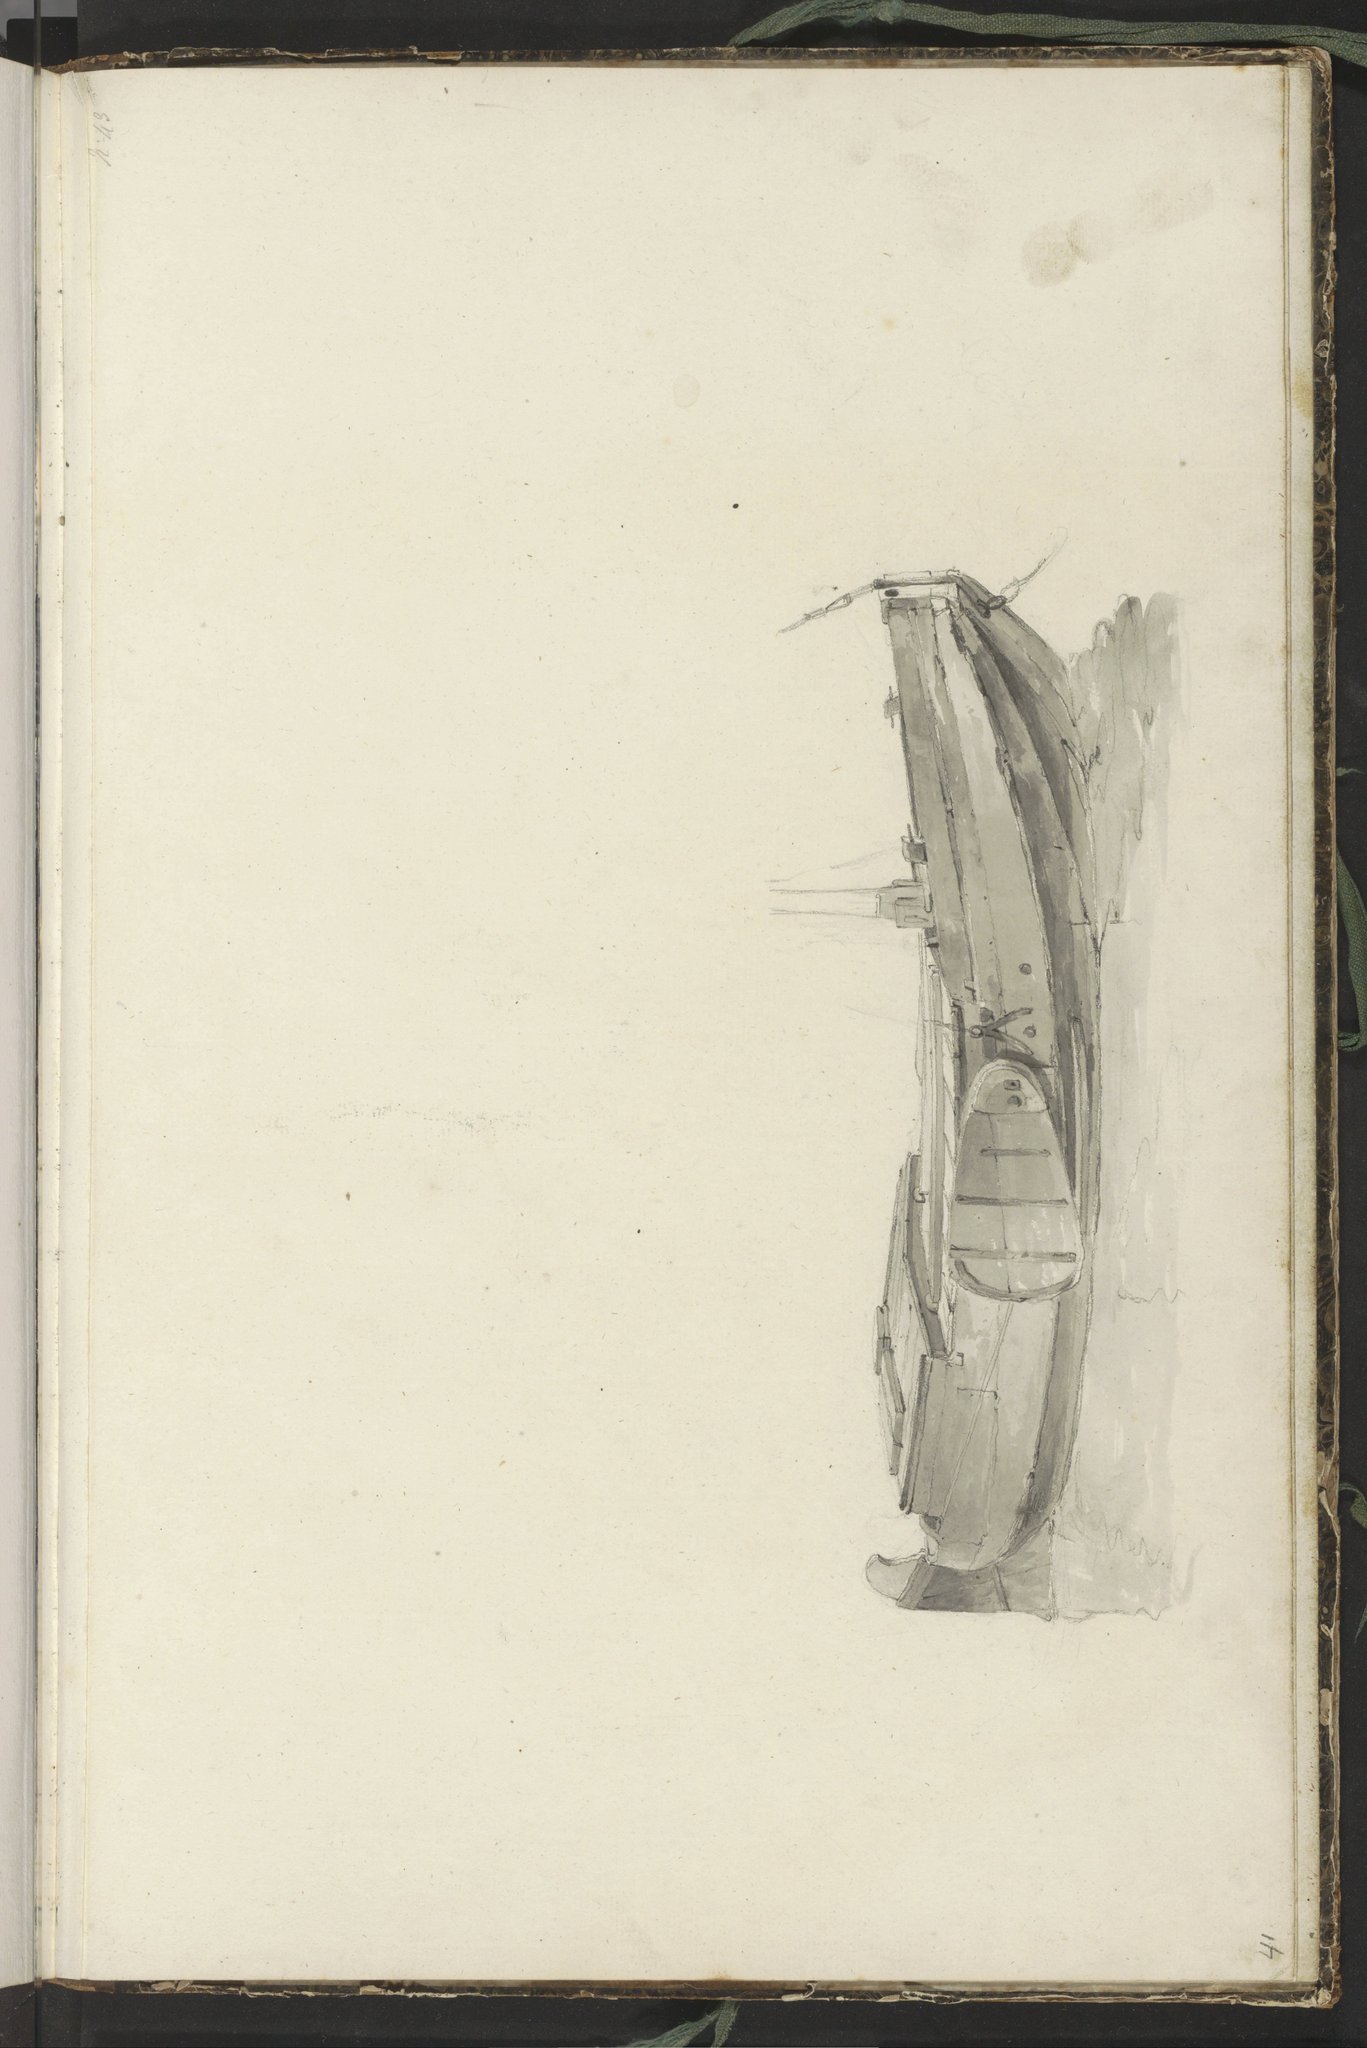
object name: sketchbook leaf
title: Zeilboot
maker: johannes christiaan schotel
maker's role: draughtsman, painter, print maker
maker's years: 1787-1838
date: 1797-1838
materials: paper, pencil, watercolor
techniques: brush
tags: sailing-ship, sailing-boat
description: Blad 41 recto uit een schetsboek met 44 bladen.